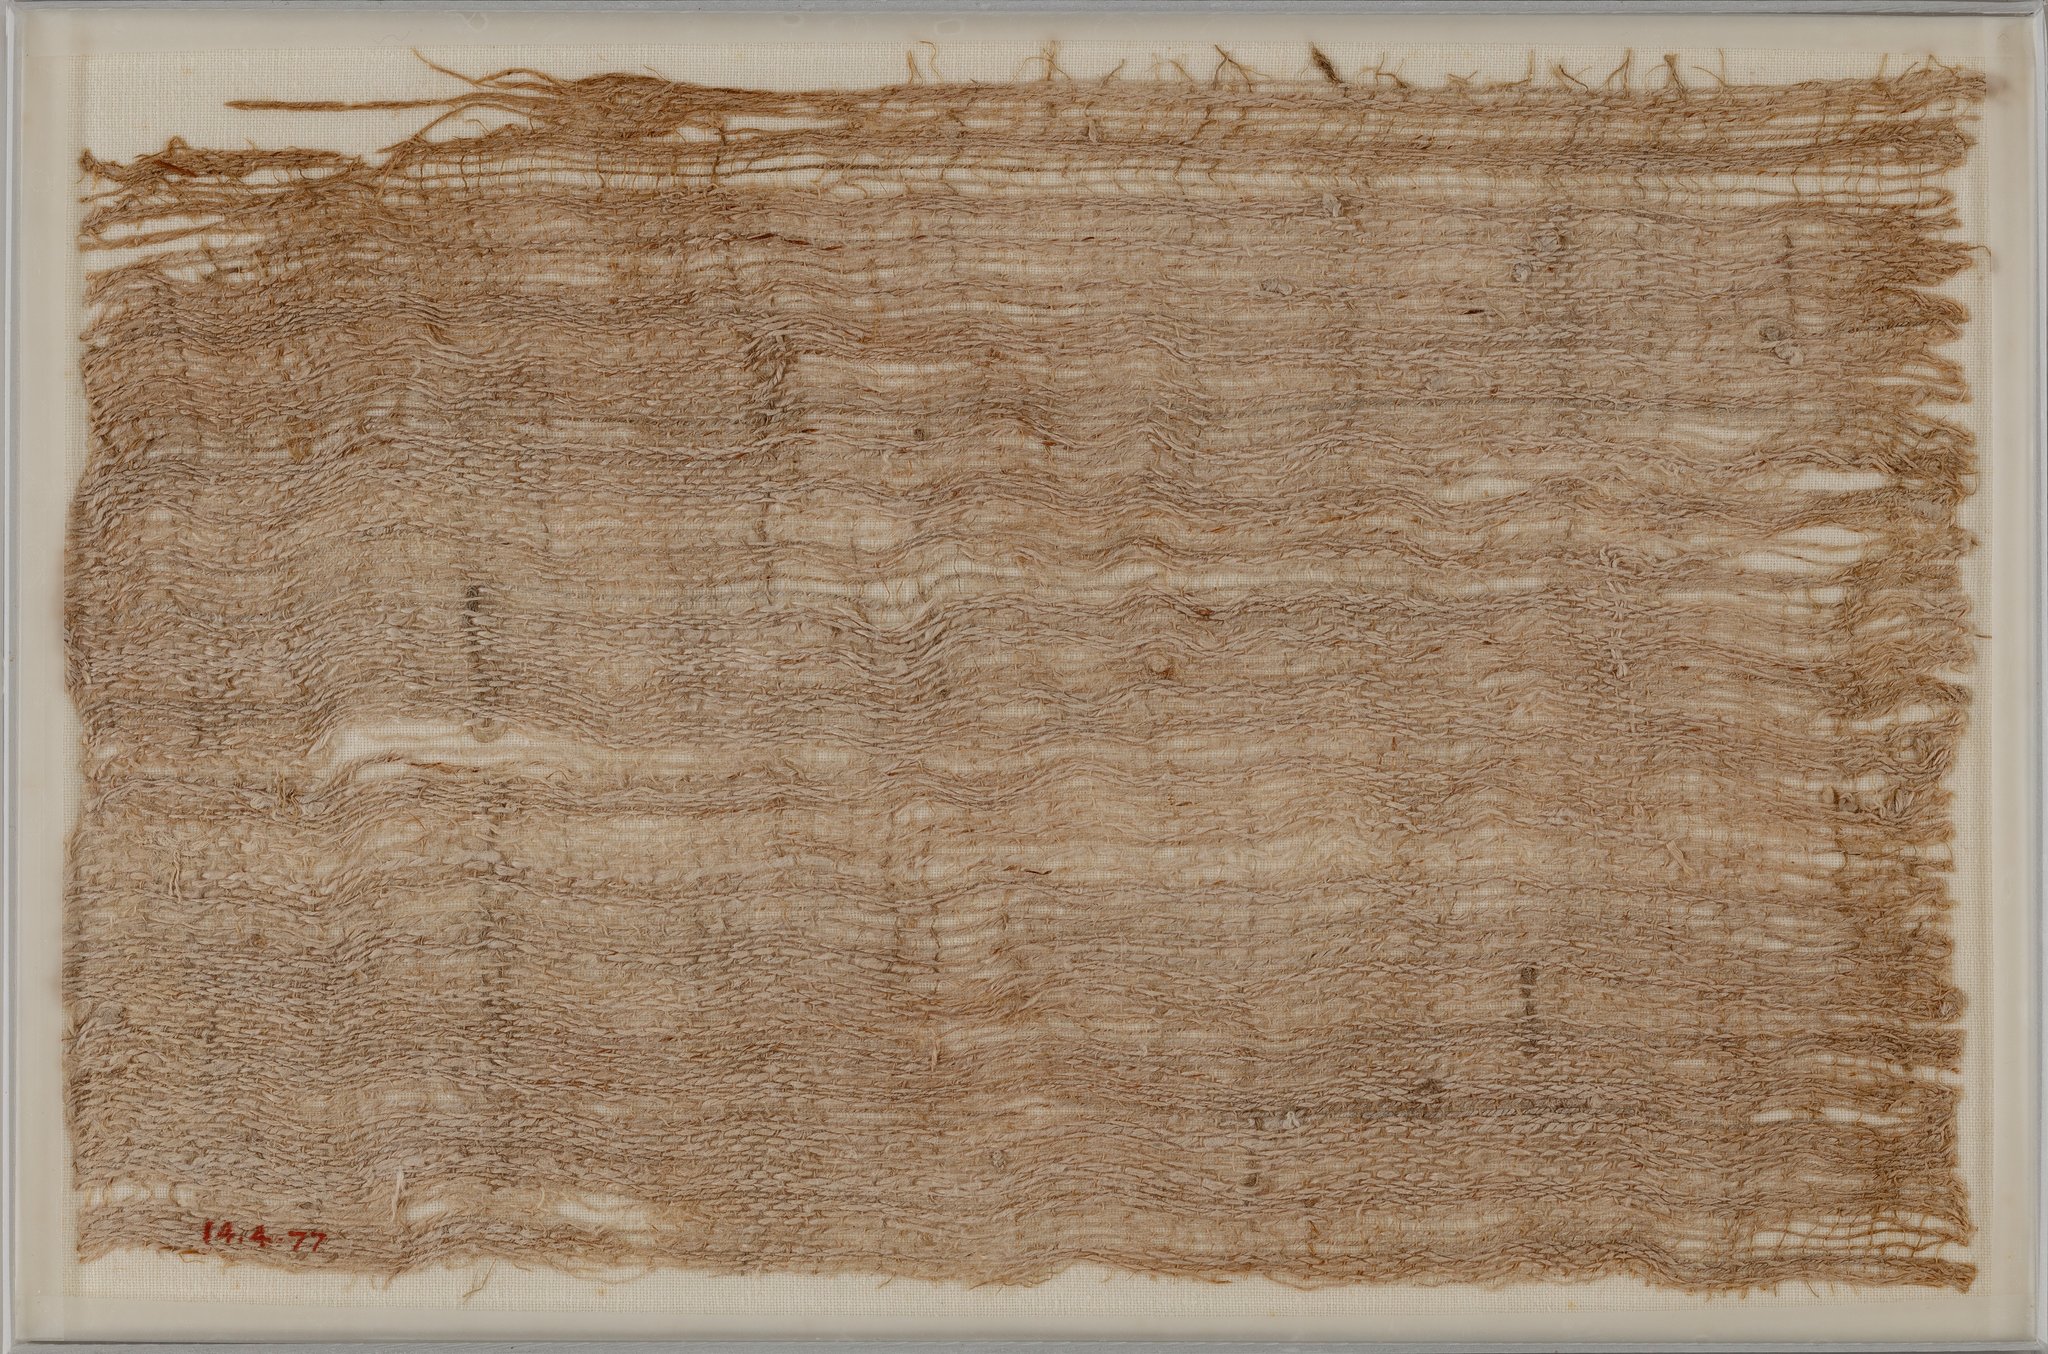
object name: linen fragment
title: A fragment from a gauzy material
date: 3000 BCE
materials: linen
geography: egypt